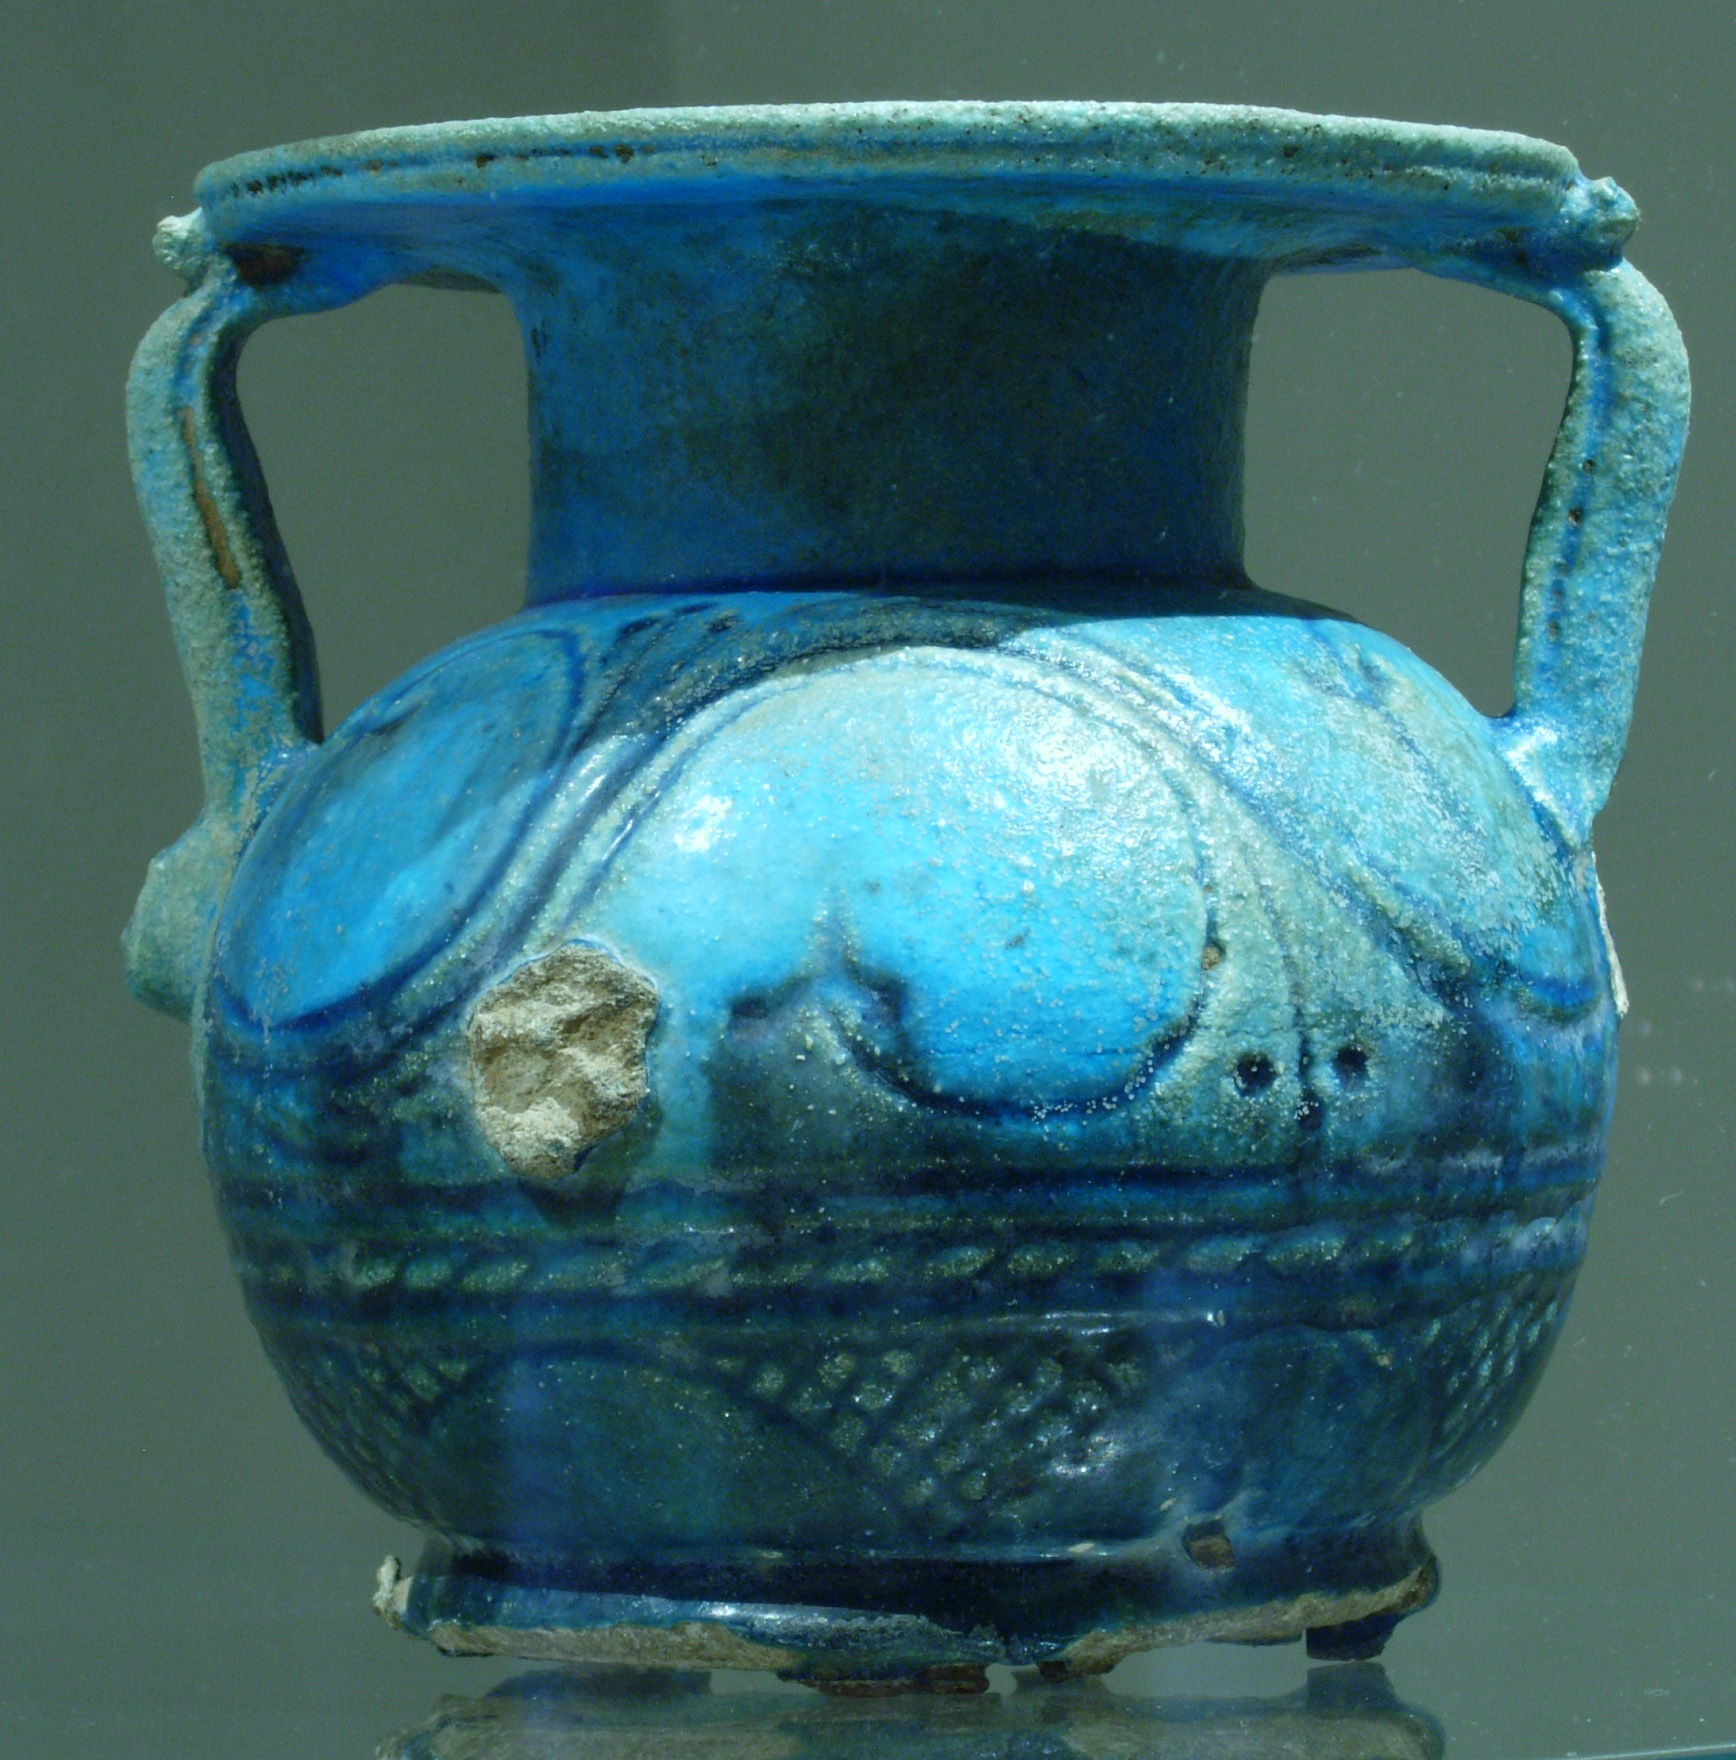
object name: vase with lid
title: Two-handled Jar with Lid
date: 1-200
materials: faience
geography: egypt